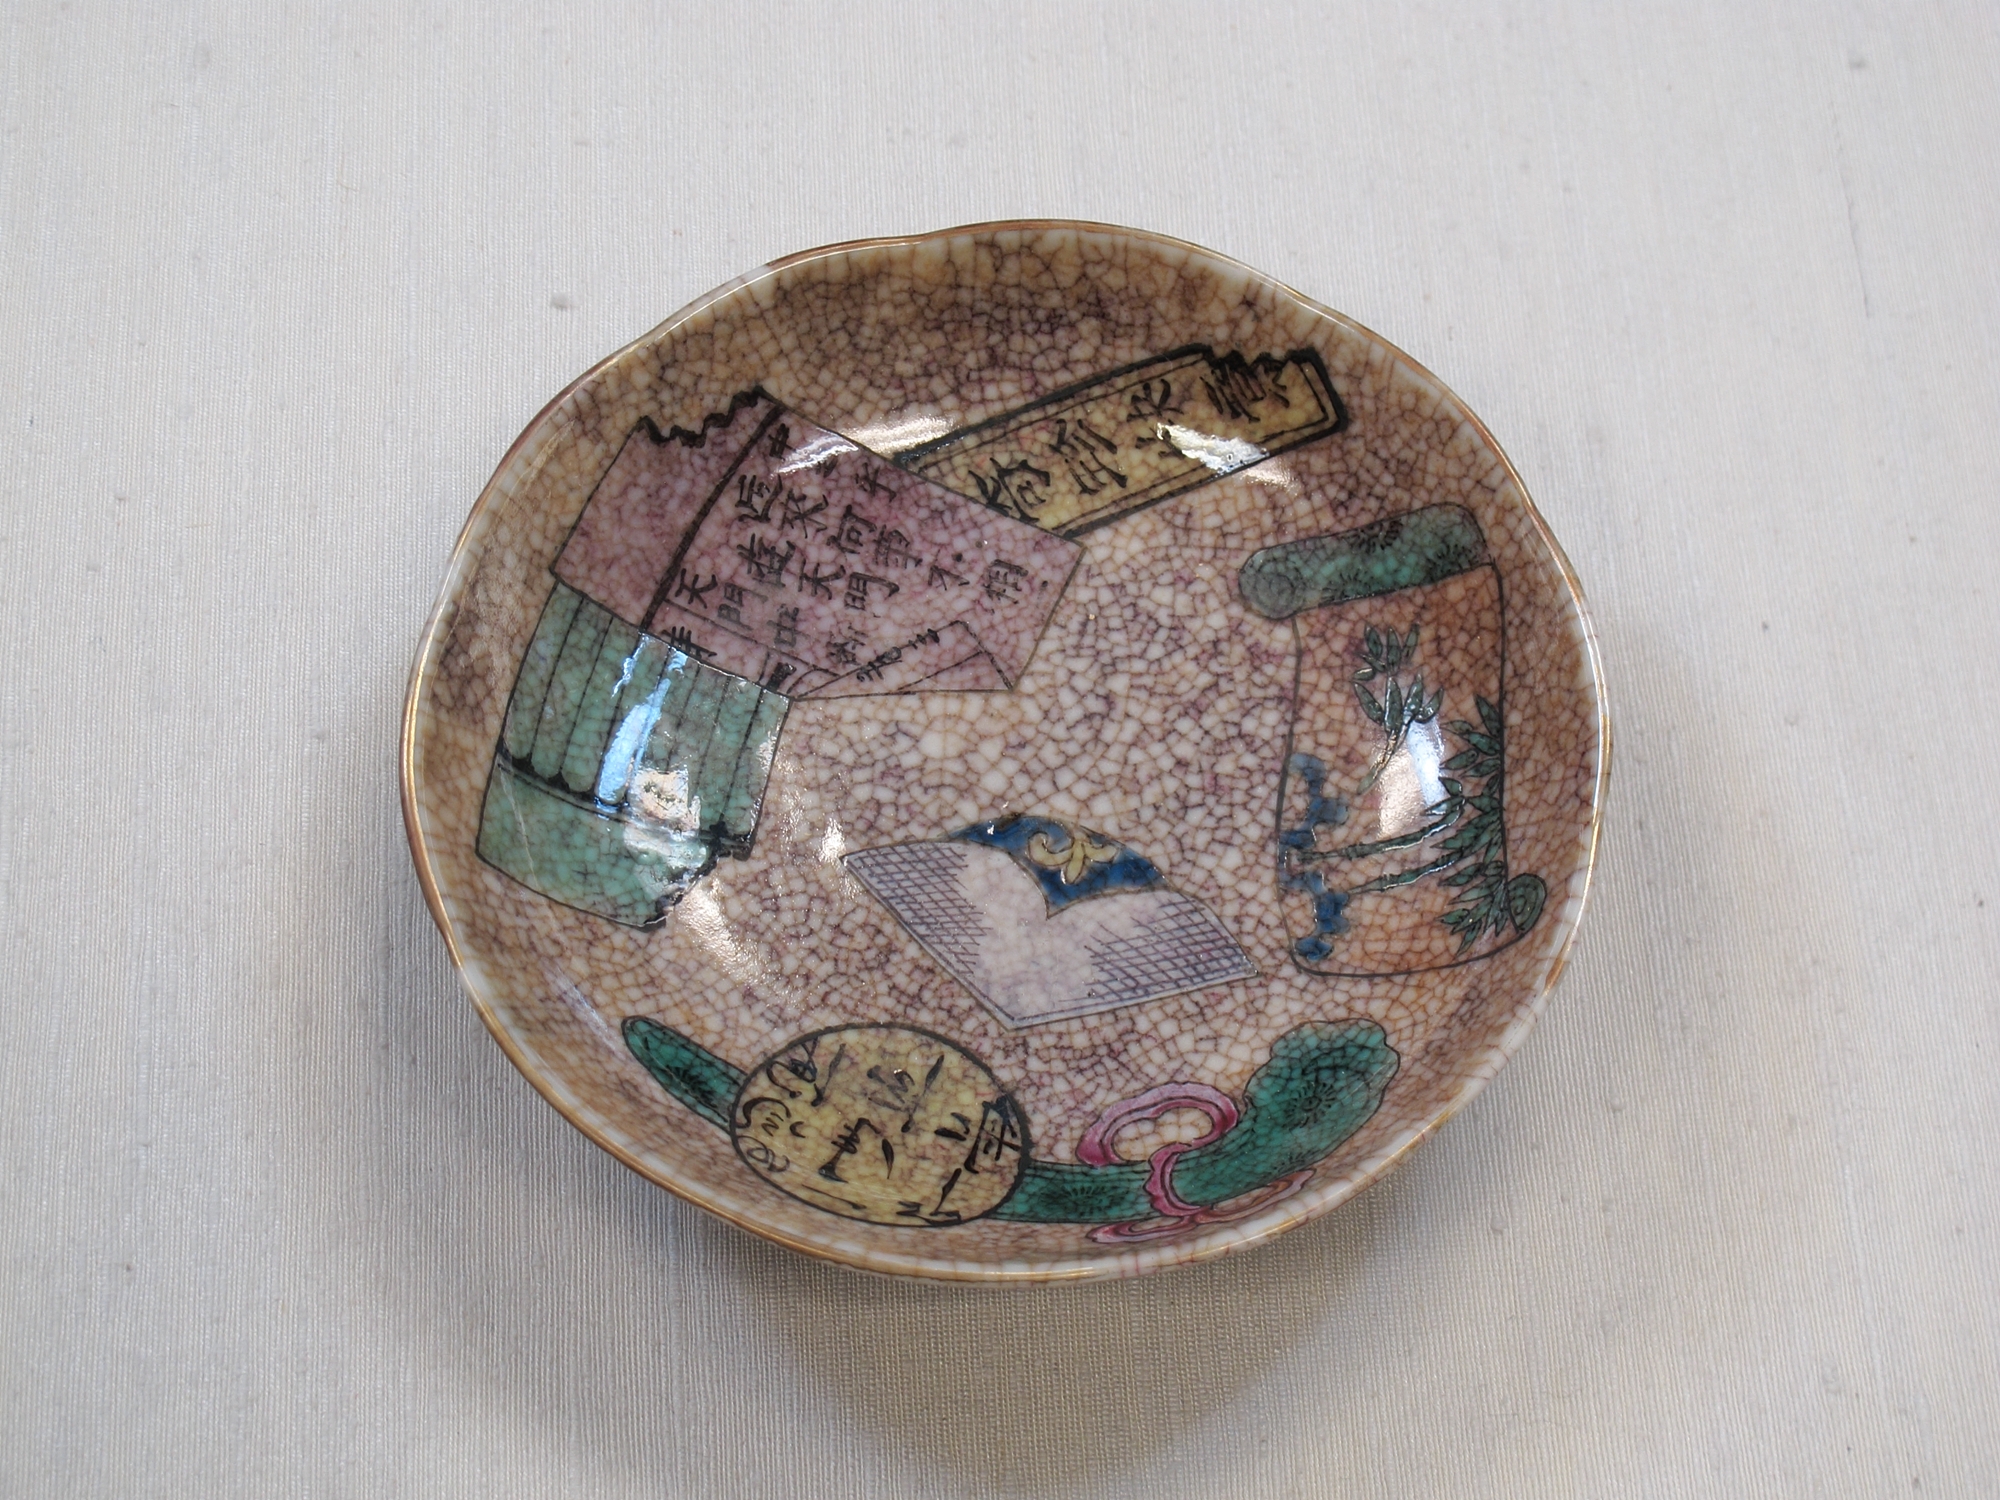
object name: dish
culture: chinese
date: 1801-1850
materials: enamel, porcelain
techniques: overglaze, painting, polychrome